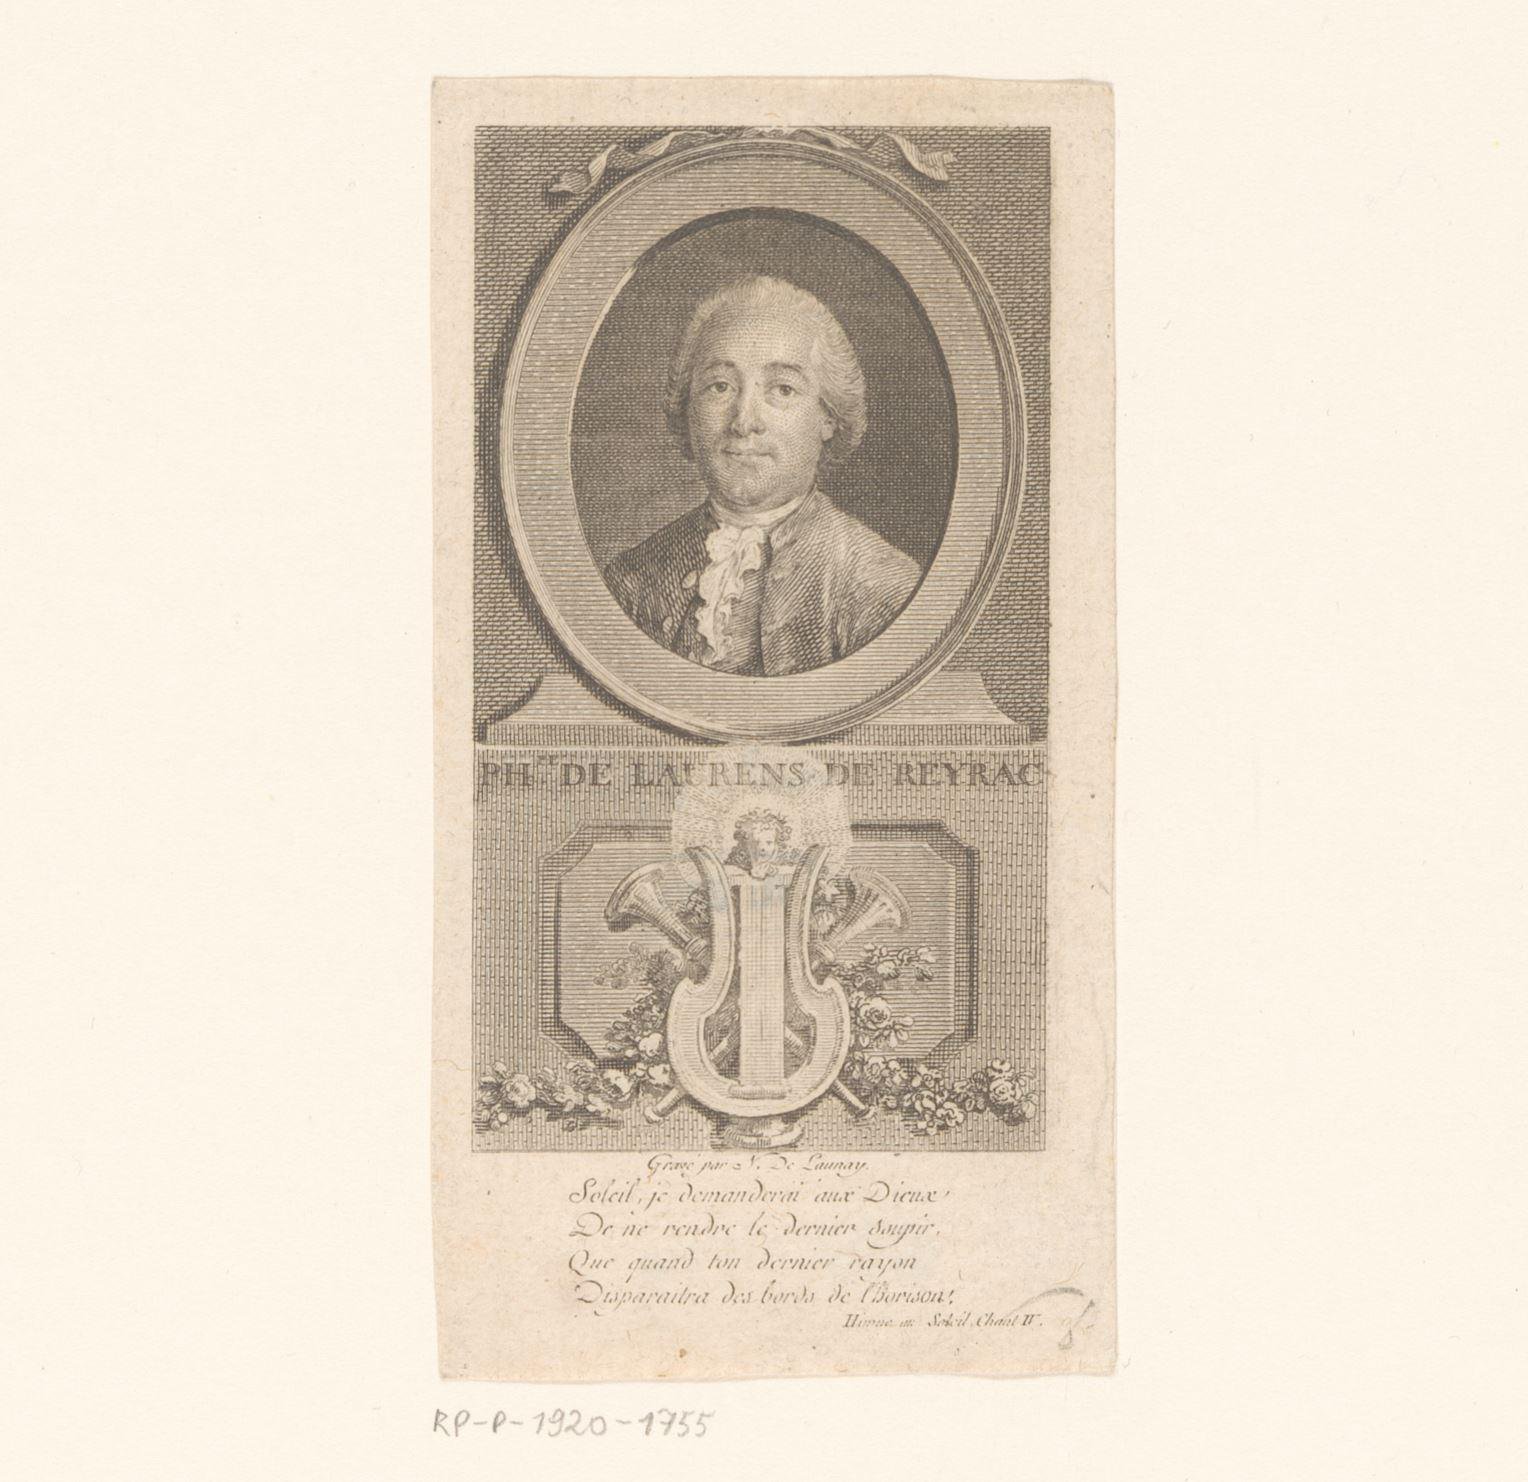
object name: print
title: Portret van Philippe Laurens de Reyrac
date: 1754-1792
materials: paper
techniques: etching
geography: france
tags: philippe laurens de reyrac, historical persons, portrait of a writer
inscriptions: collector's mark: Lugt 2228